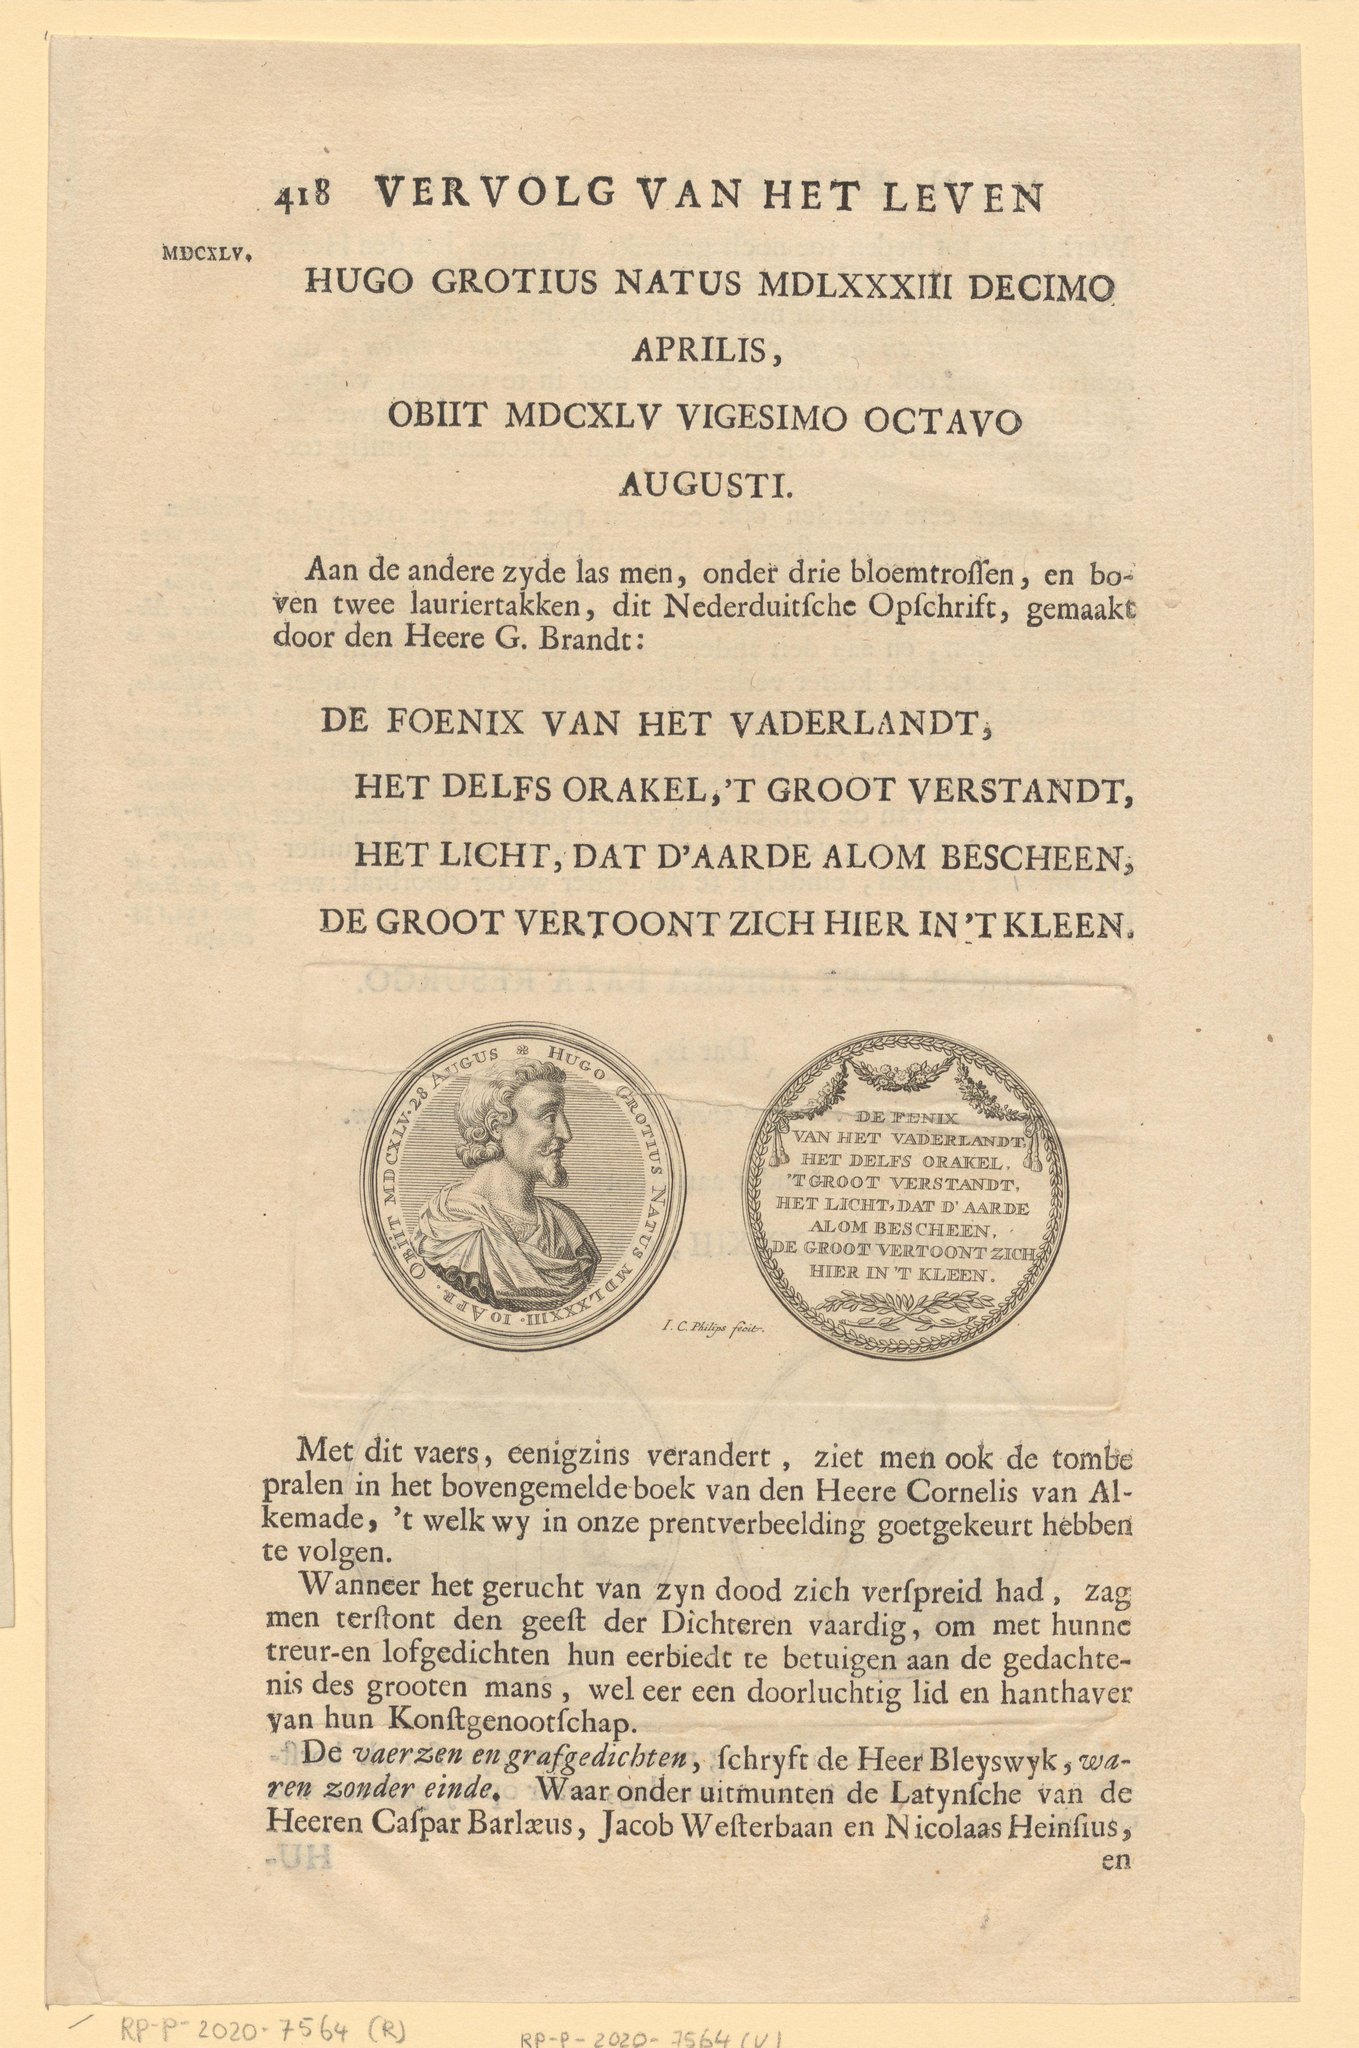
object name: print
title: Gedenkpenning met het portret van Hugo de Groot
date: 1727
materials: paper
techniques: engraving, letterpress printing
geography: amsterdam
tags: delft, hugo de groot, historical persons, memorial medal, portrait of a writer, medal (considered as a piece of sculpture, regardless of its specific function)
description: Prent uit: Brandt, Caspar en Adriaan van Cattenburgh. Historie van het leven des heeren Huig de Groot. Dordrecht: Johannes van Braam, Amsterdam: Gerard Onder de Linden, 1727, p. 418.